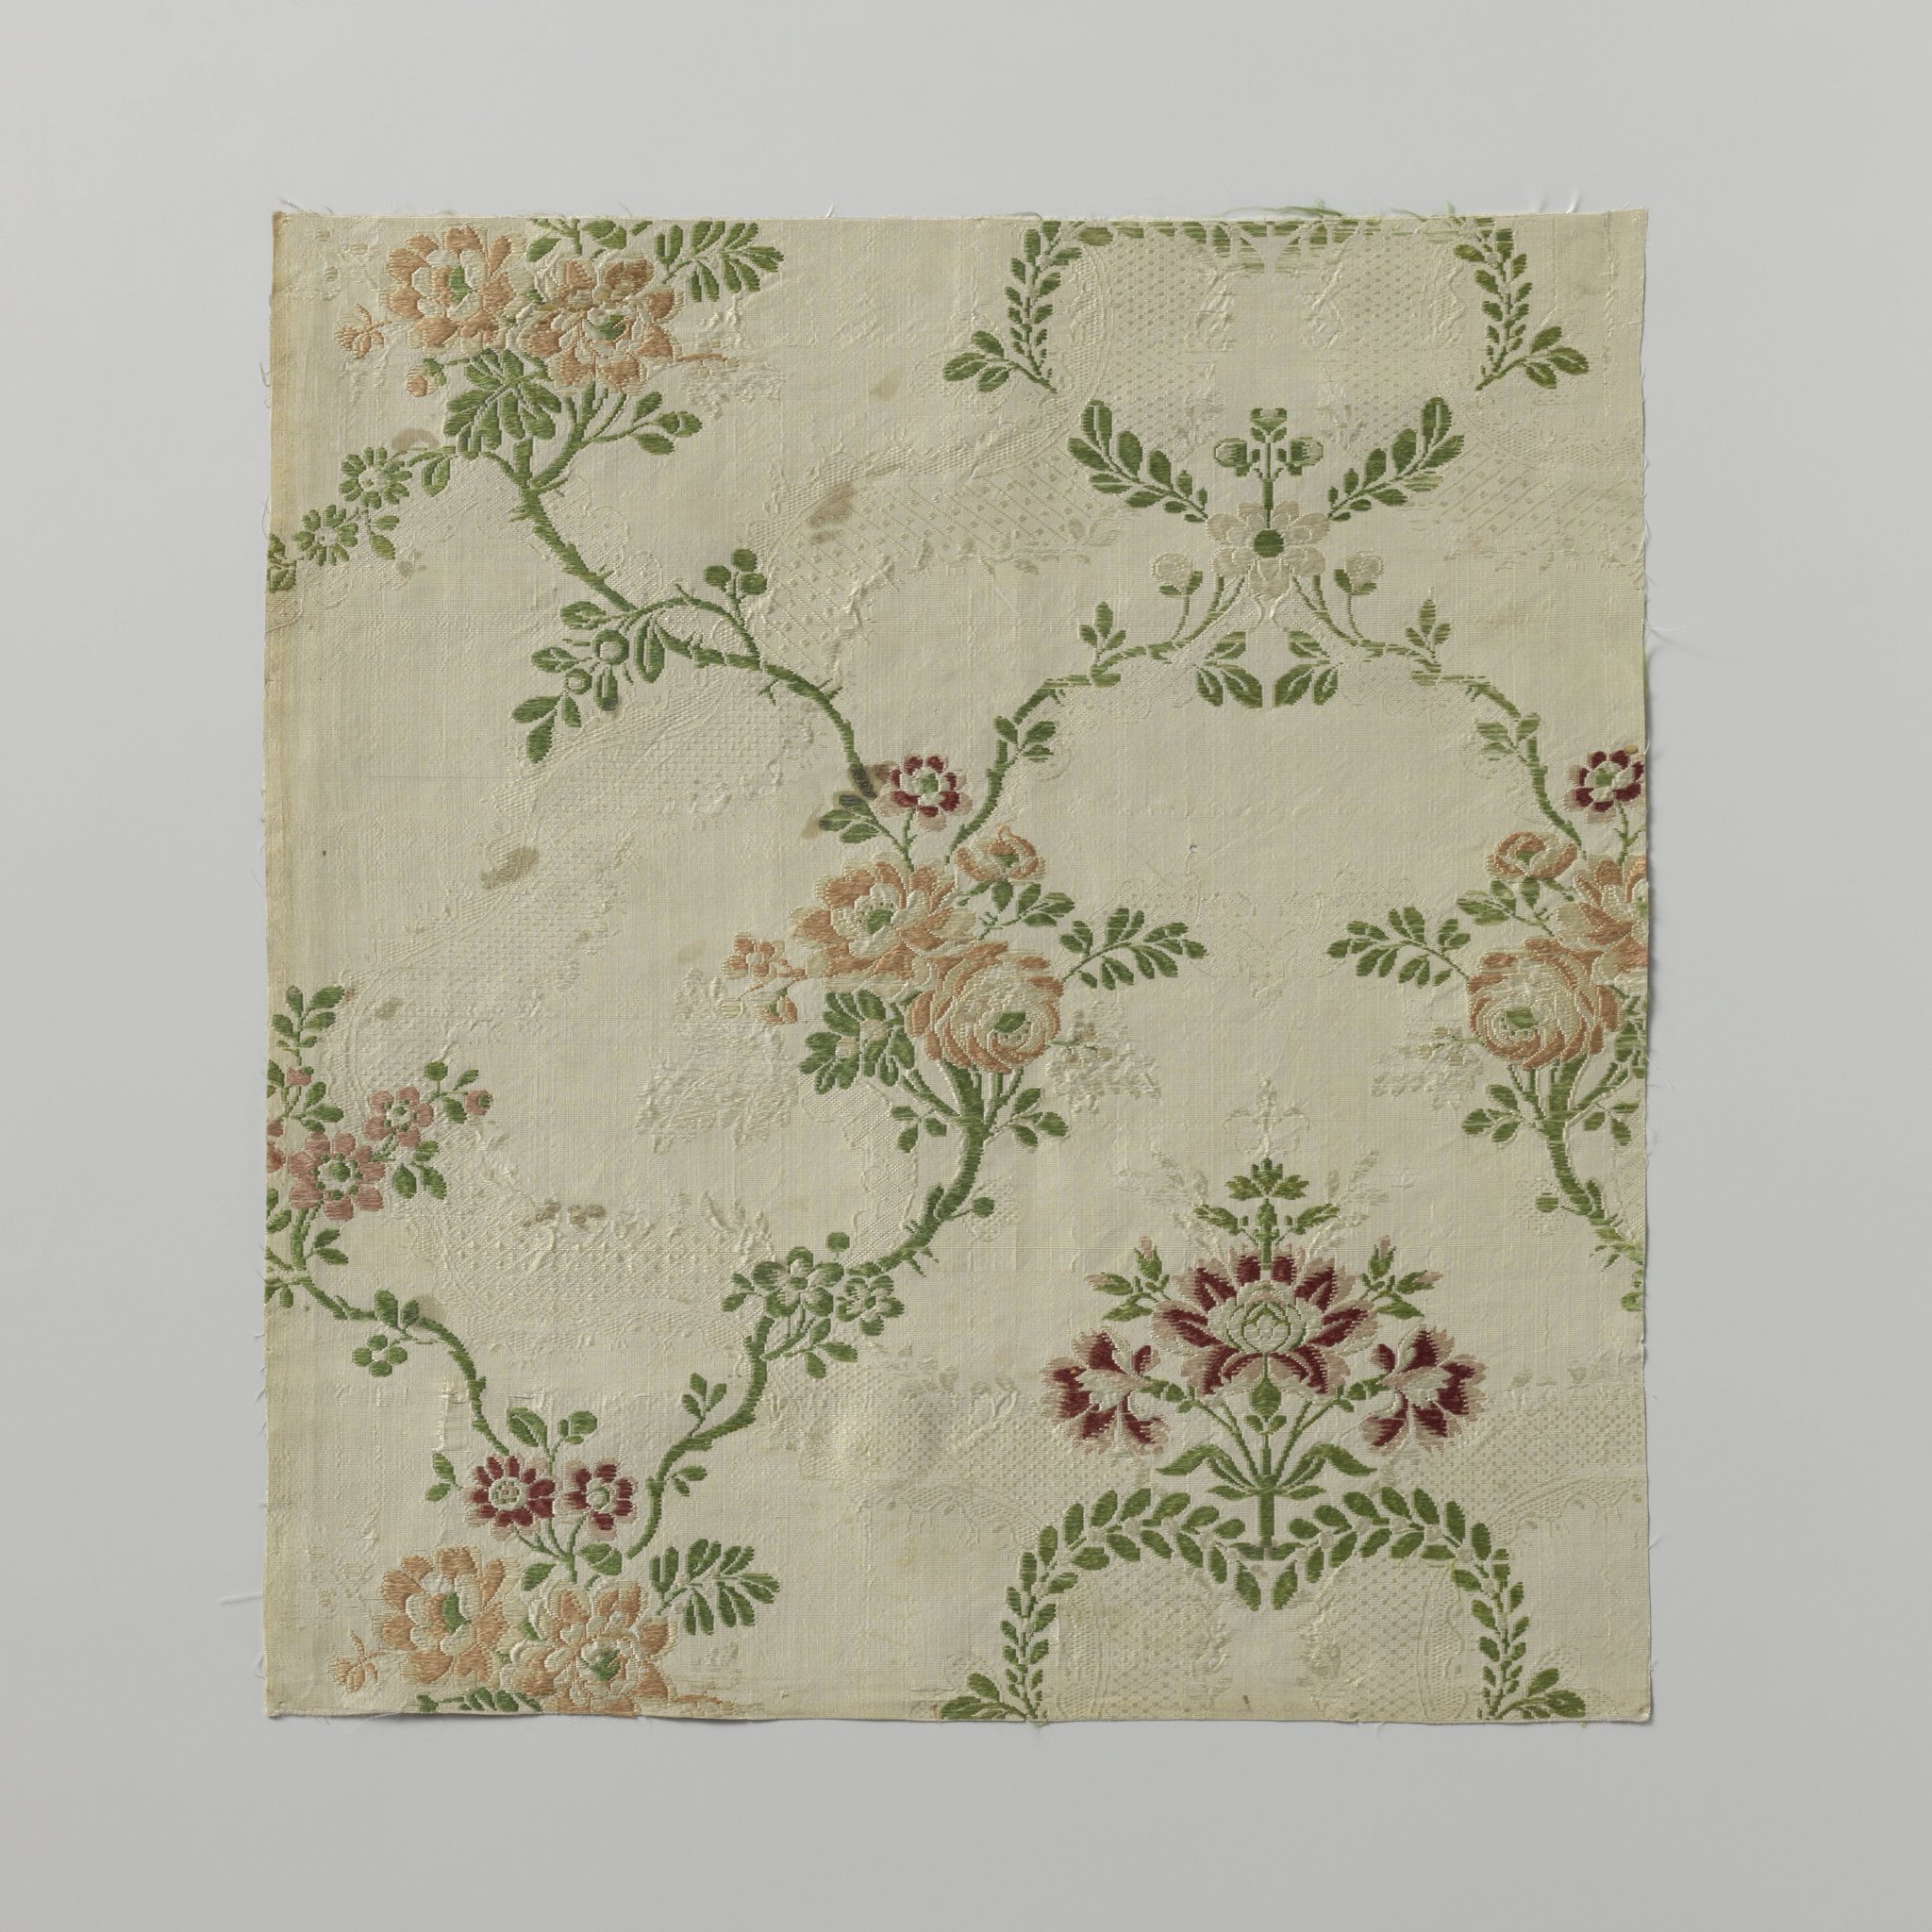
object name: fragment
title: Fragment veelkleurige gebrocheerde zijde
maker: Anonymous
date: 1740-1760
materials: silk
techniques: brocade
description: Fragment wit zijdeweefsel met witte kantslingers waartussen veelkleurige bloemranken.